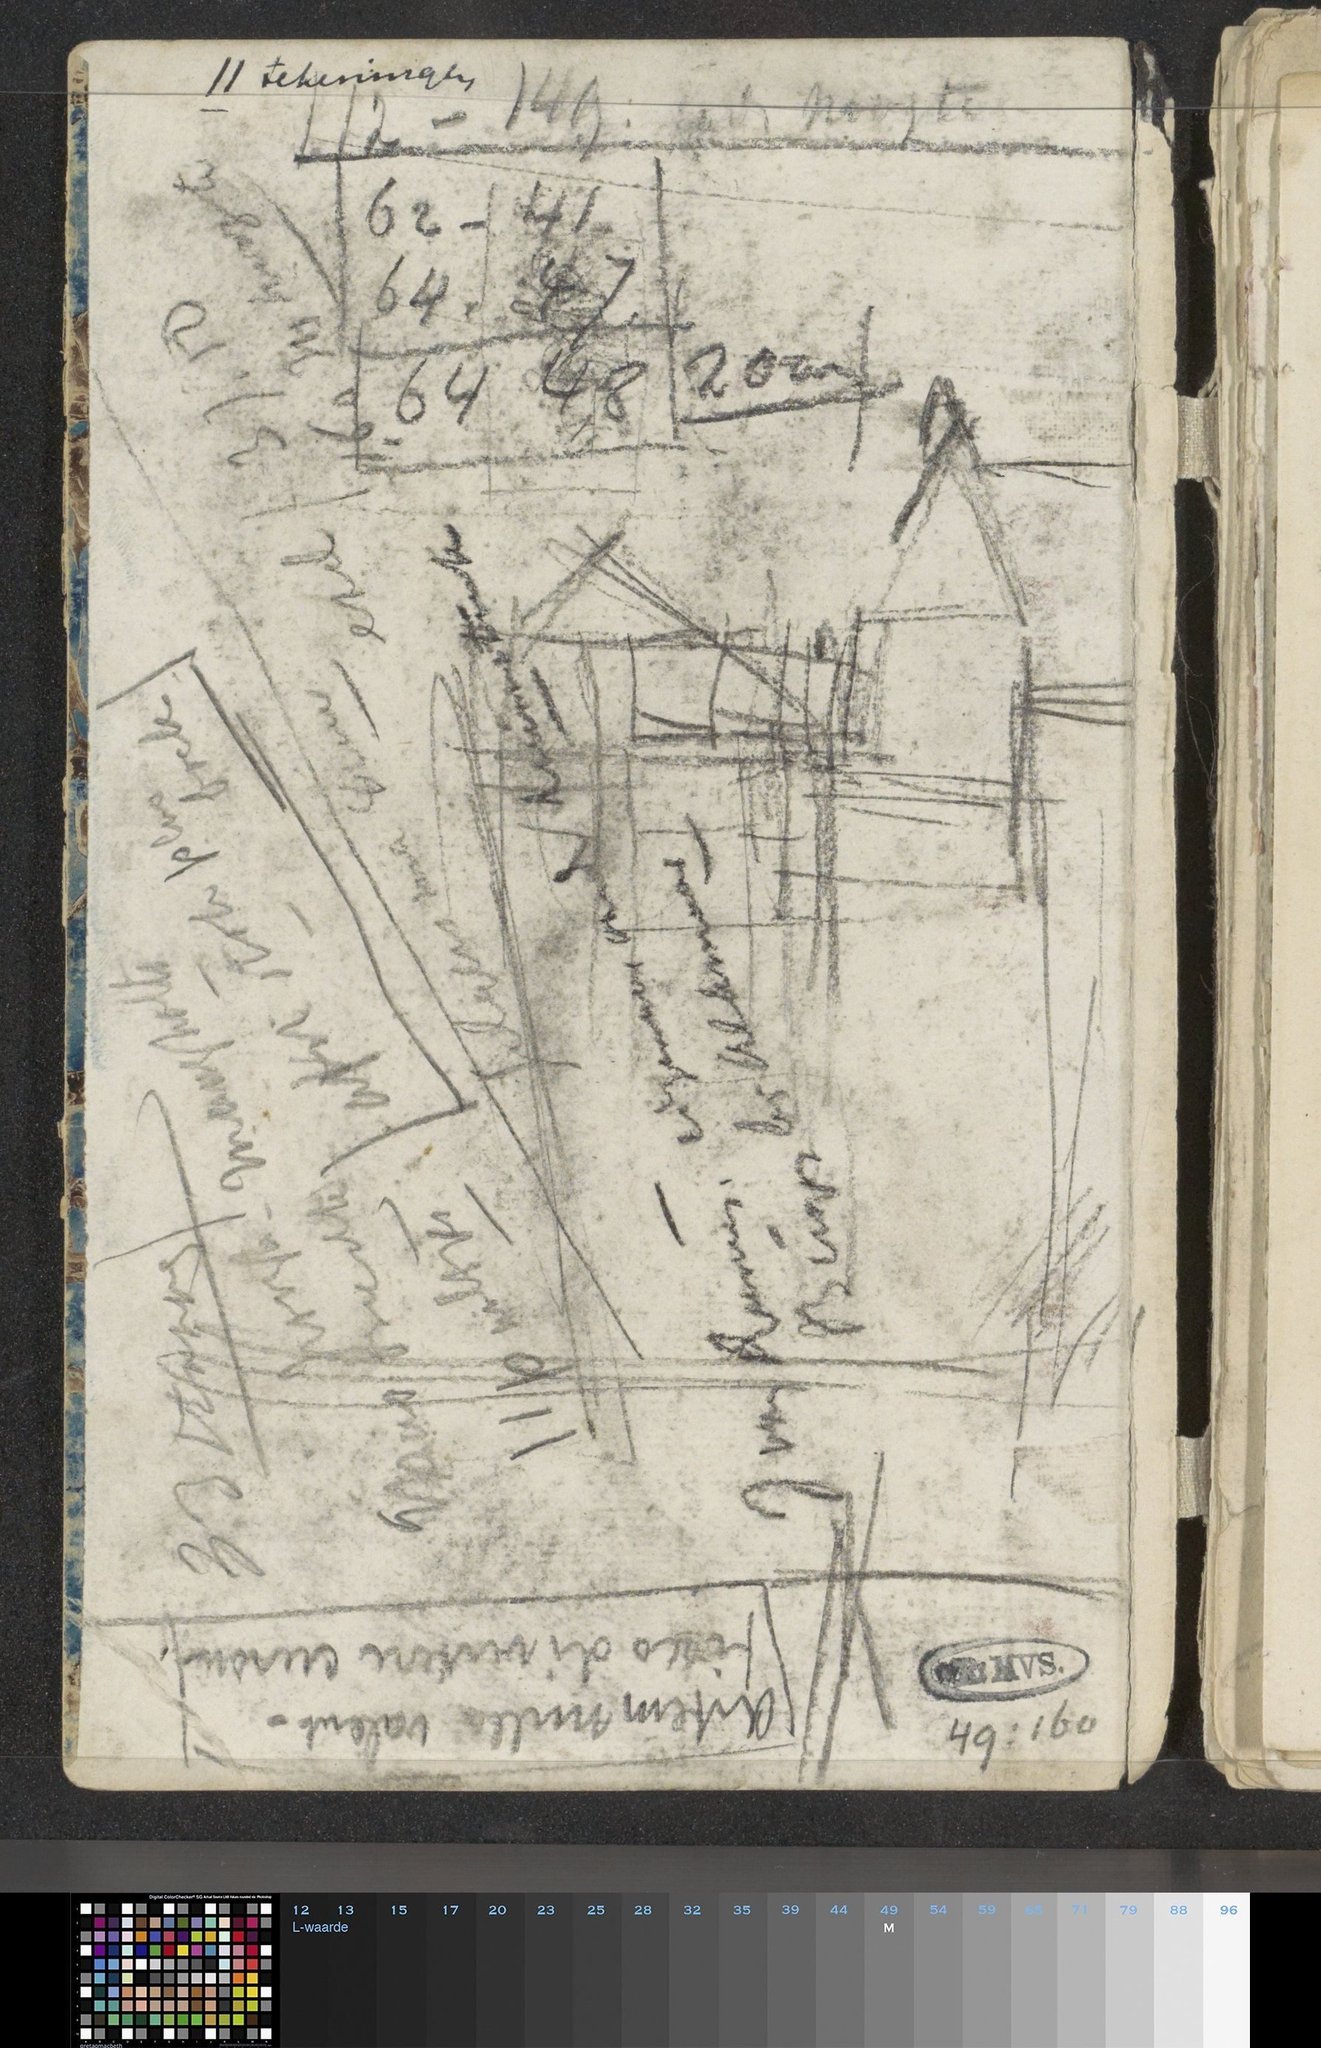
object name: endleaf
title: Architectuurstudie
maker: george hendrik breitner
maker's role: draughtsman, painter, print maker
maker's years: 1857-1923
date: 1886-1923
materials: chalk, paper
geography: amsterdam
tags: architecture, civic architecture; edifices; dwellings, amsterdam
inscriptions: collector's mark: Lugt 2228, annotation: ‘[...]’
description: Pagina 1, voorste schutblad, uit een schetsboek met 19 bladen en 9 losse tekeningen.